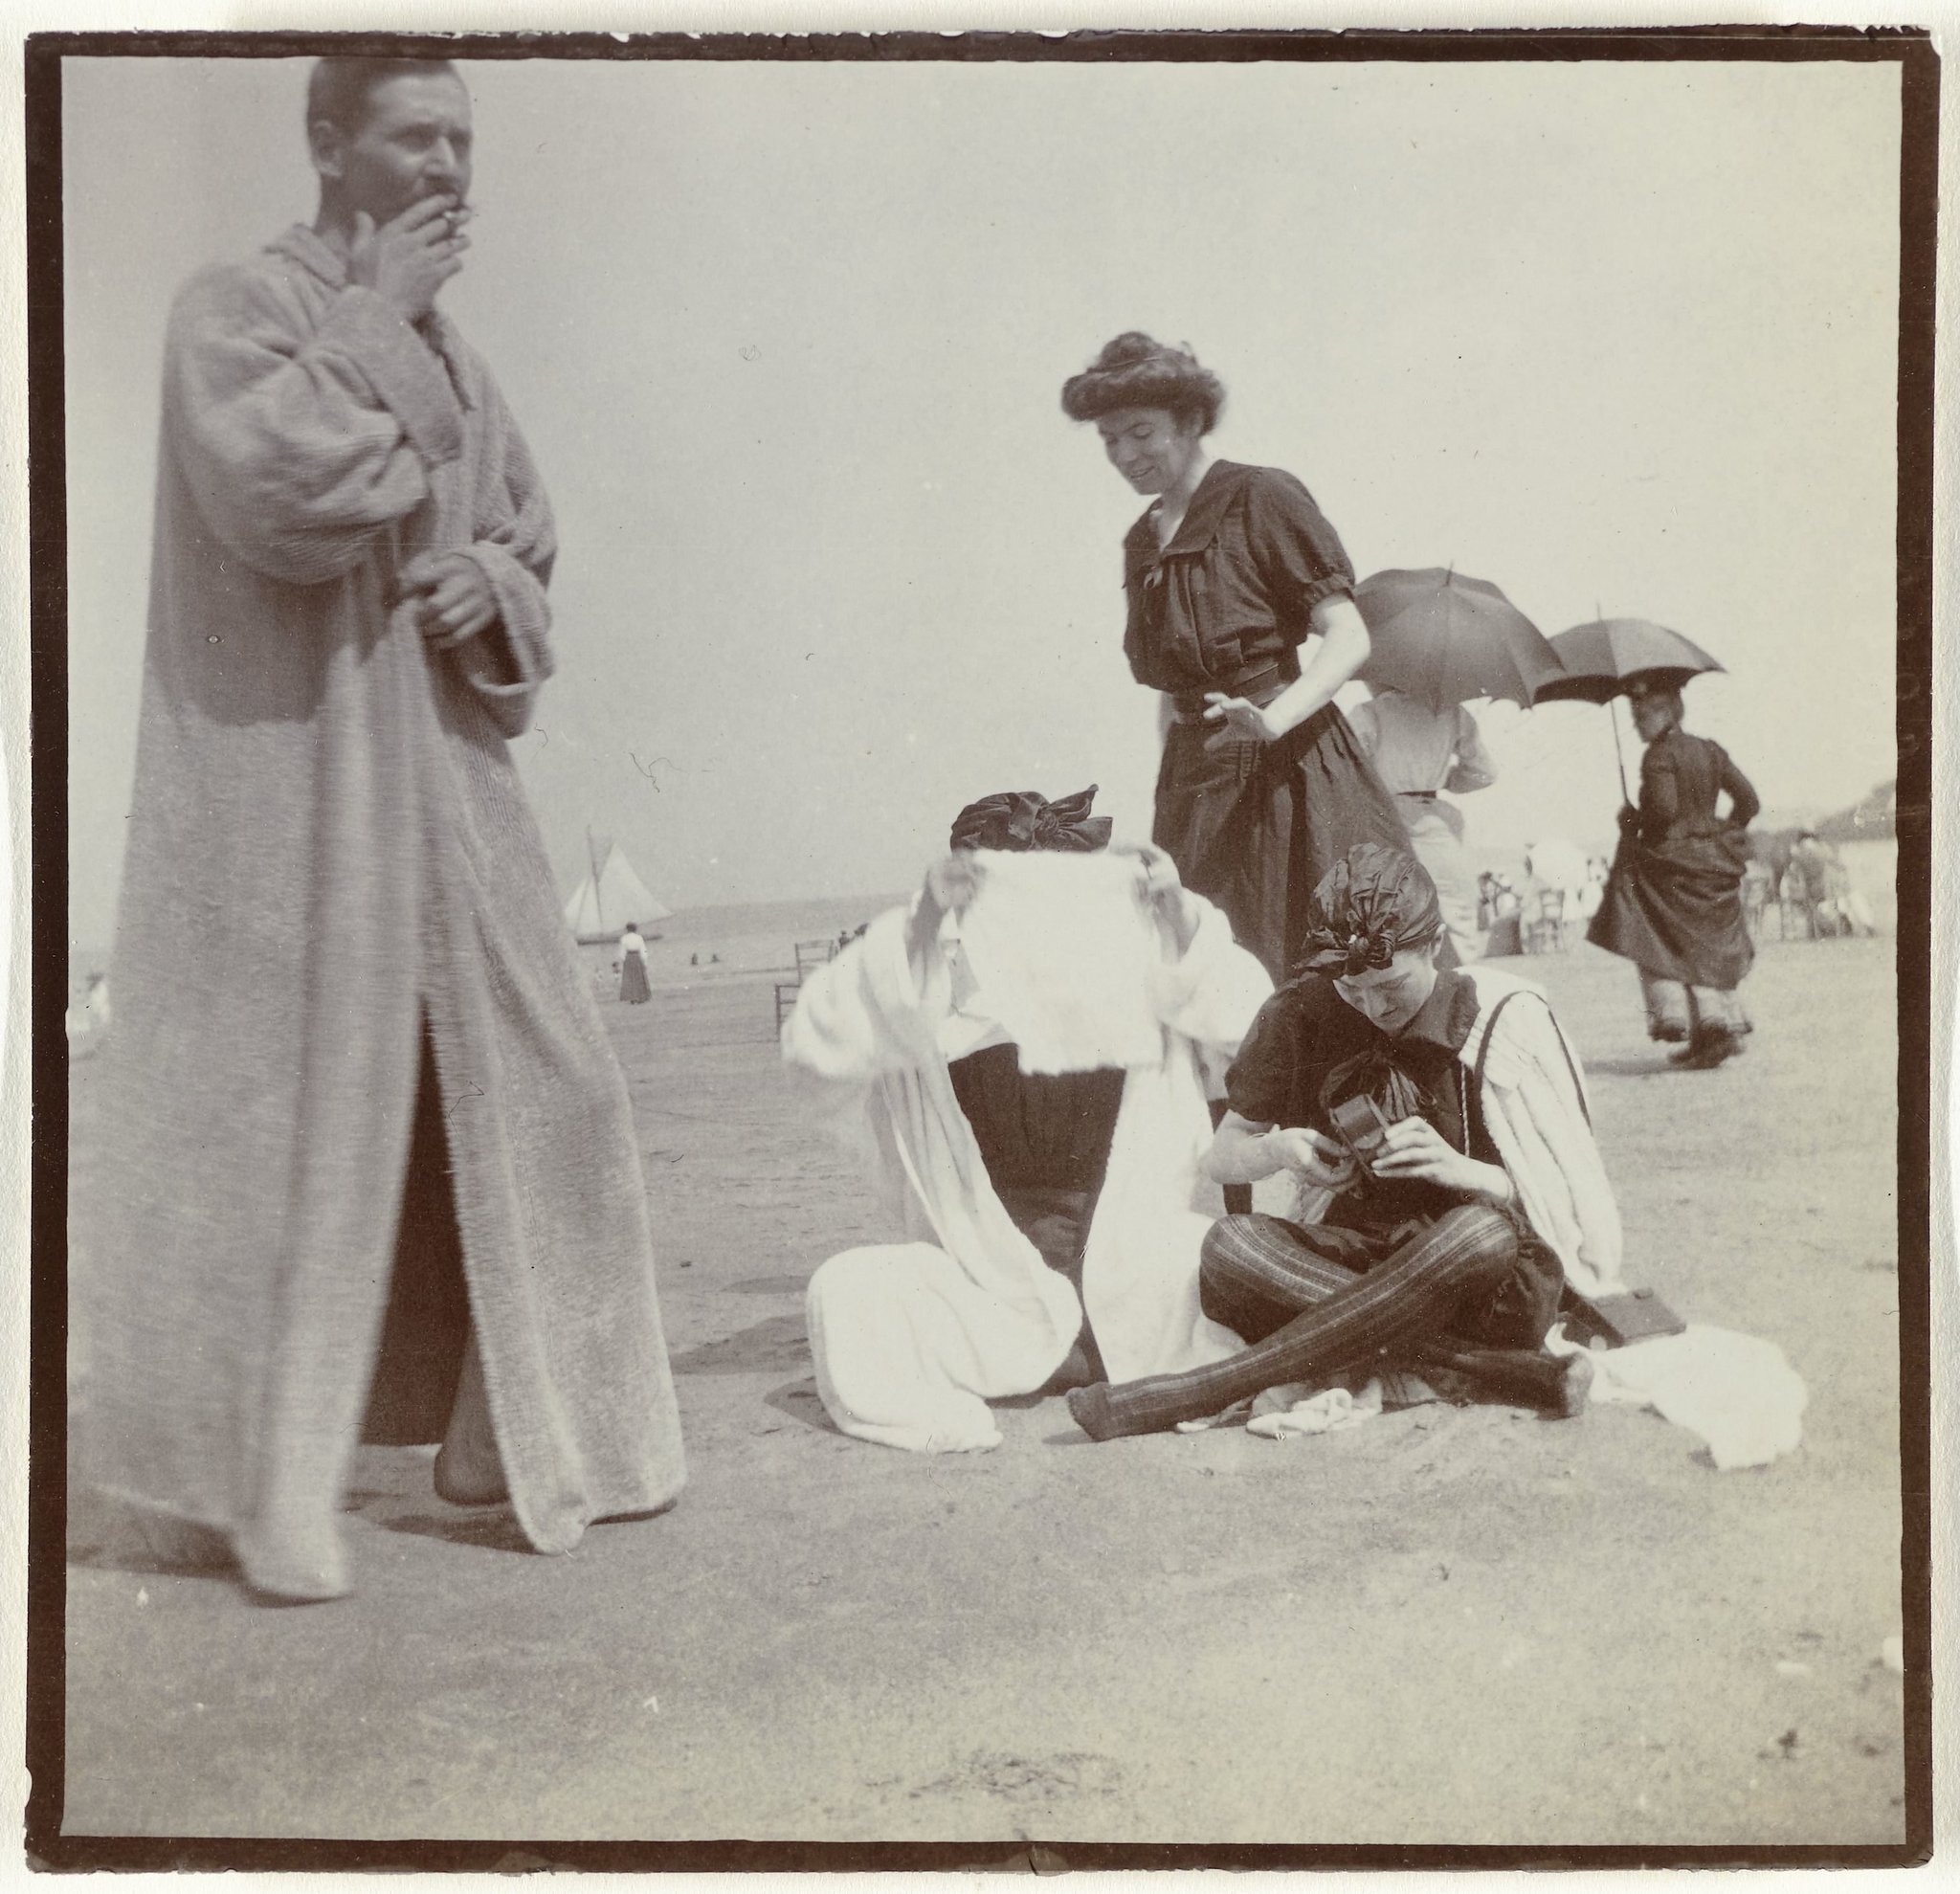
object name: photograph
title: Enthoven Girl with Friends on the Beach in Normandy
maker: Anonymous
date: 1900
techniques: photography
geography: normandy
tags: beach (as place of recreation)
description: Thanks to the handheld camera photography soon became the cheerful parlour game that we see in these Kodak photographs. Everyone on the beach is busy with their own camera and Enthoven’s Italian friends pose for and cavort with each other. One of the women holds a Pocket Kodak.